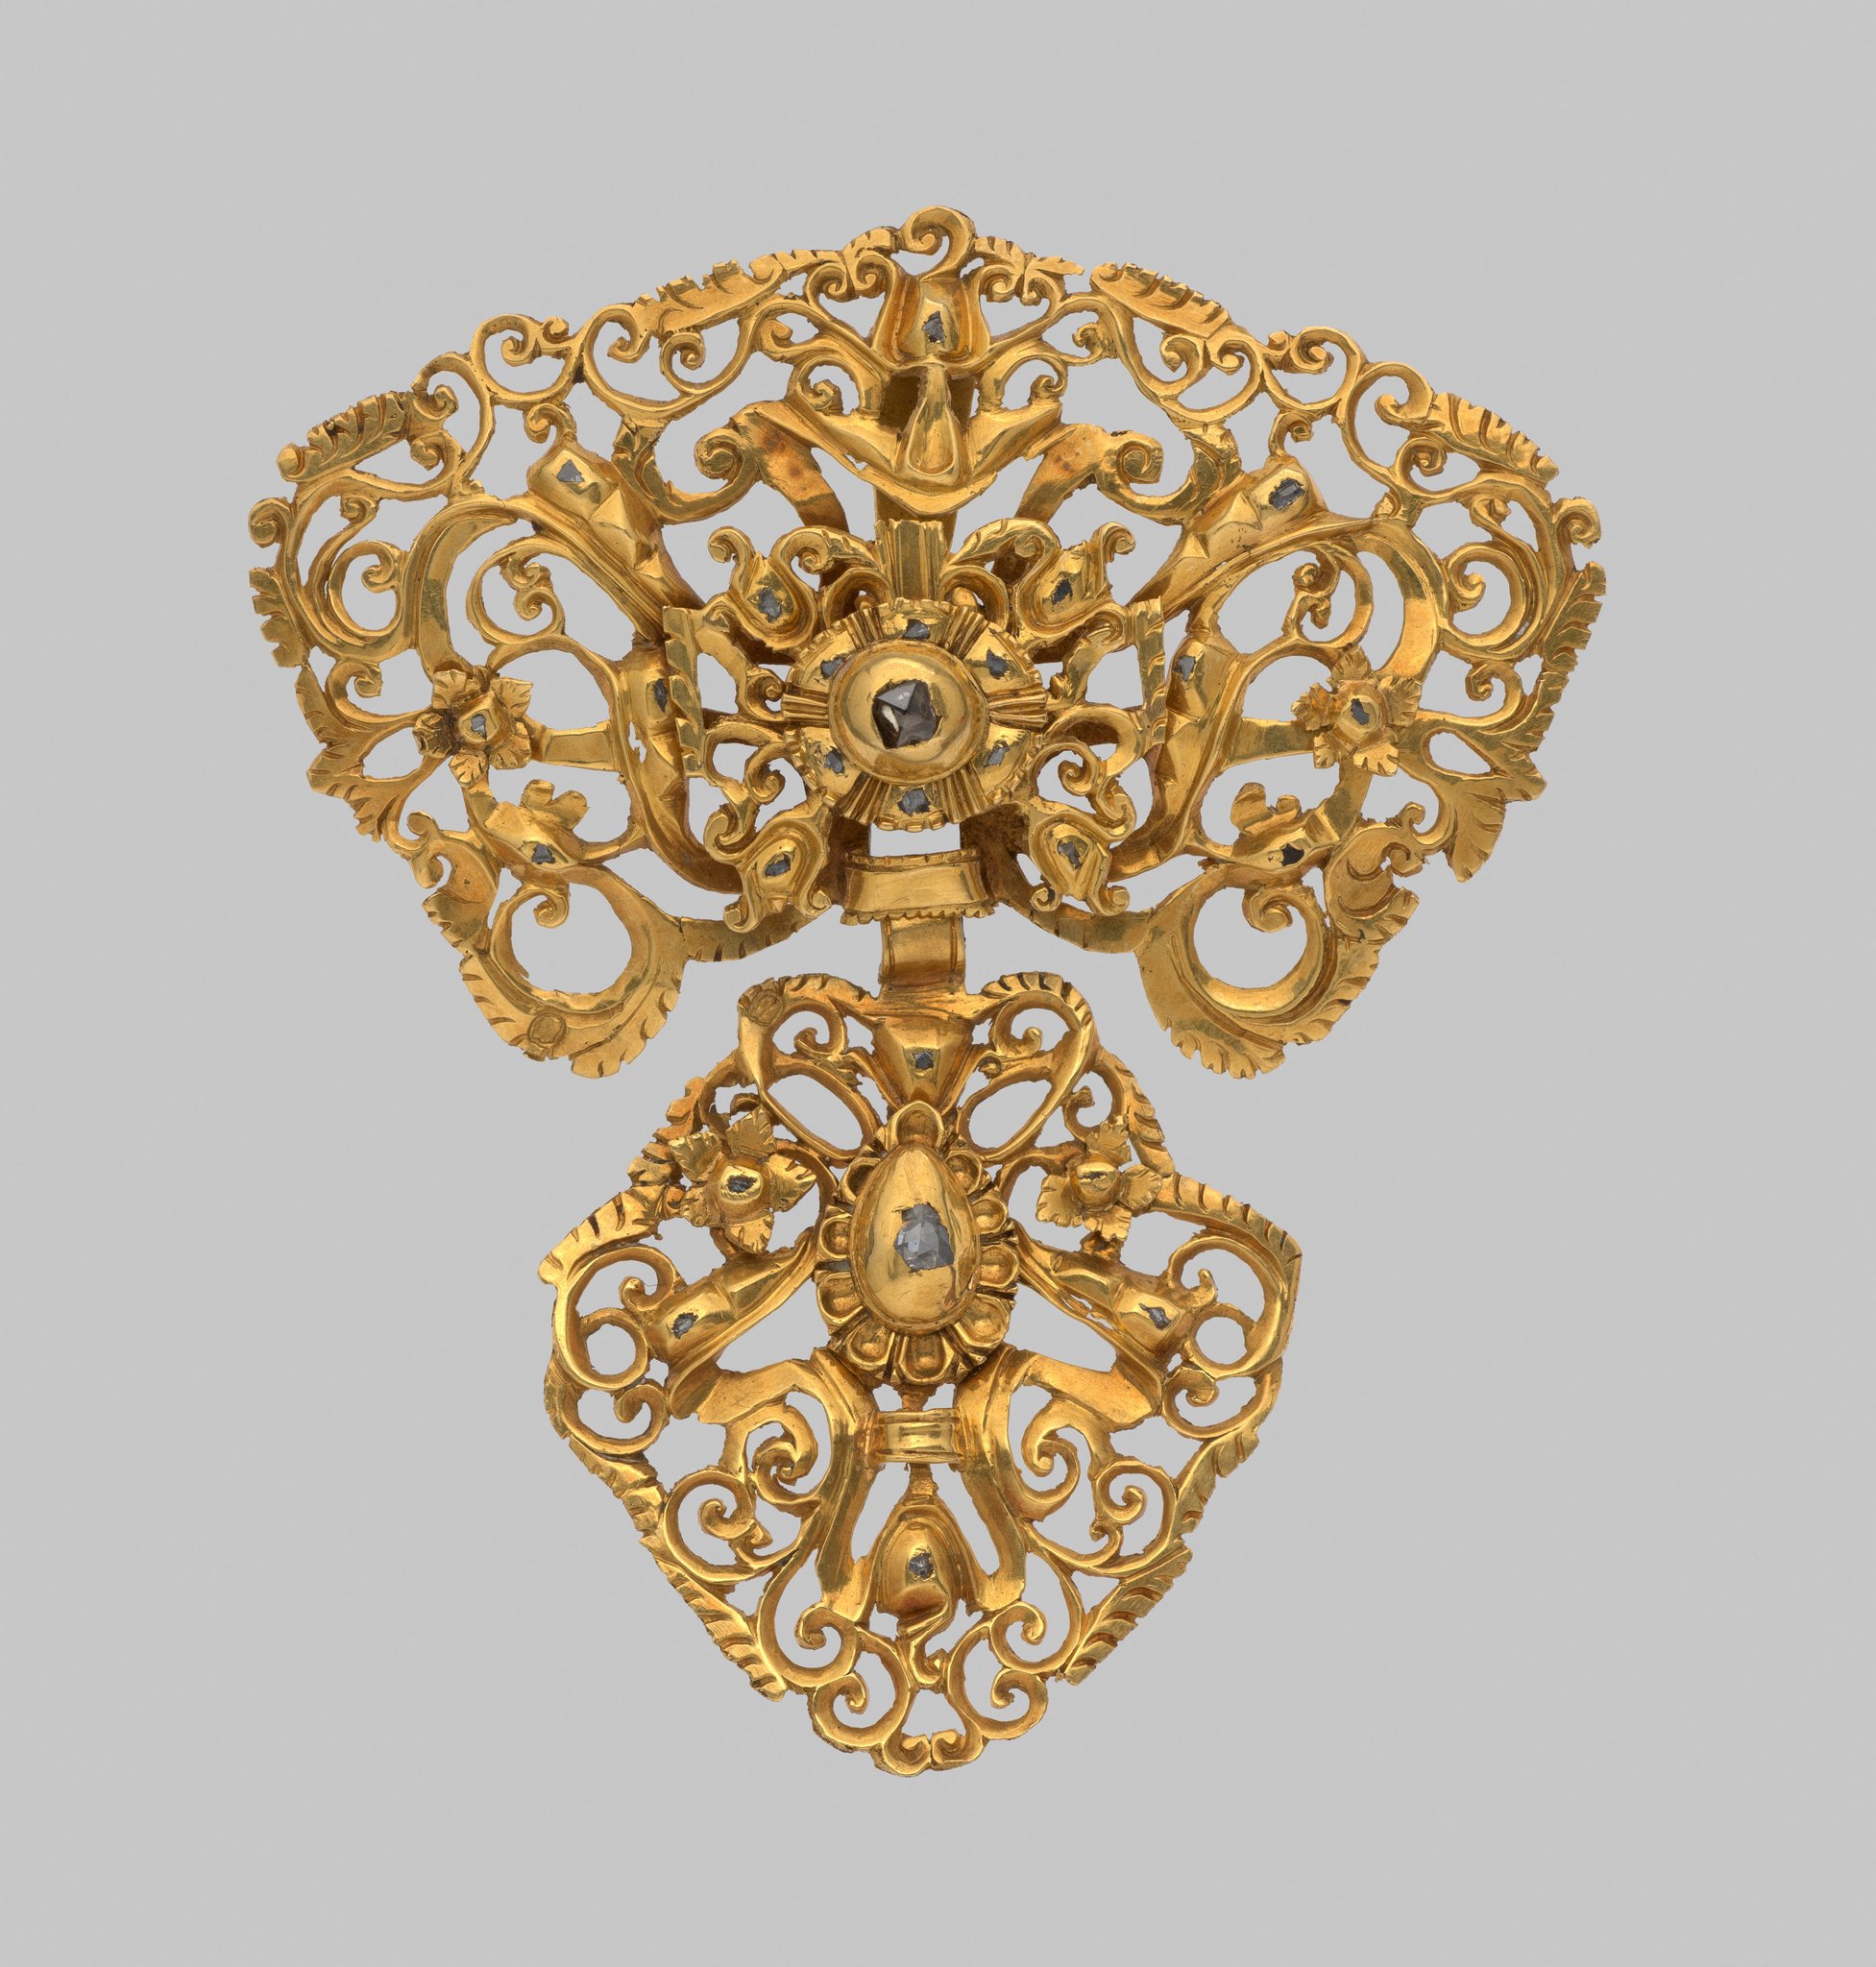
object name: pendant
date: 1701-1800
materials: diamond, gold